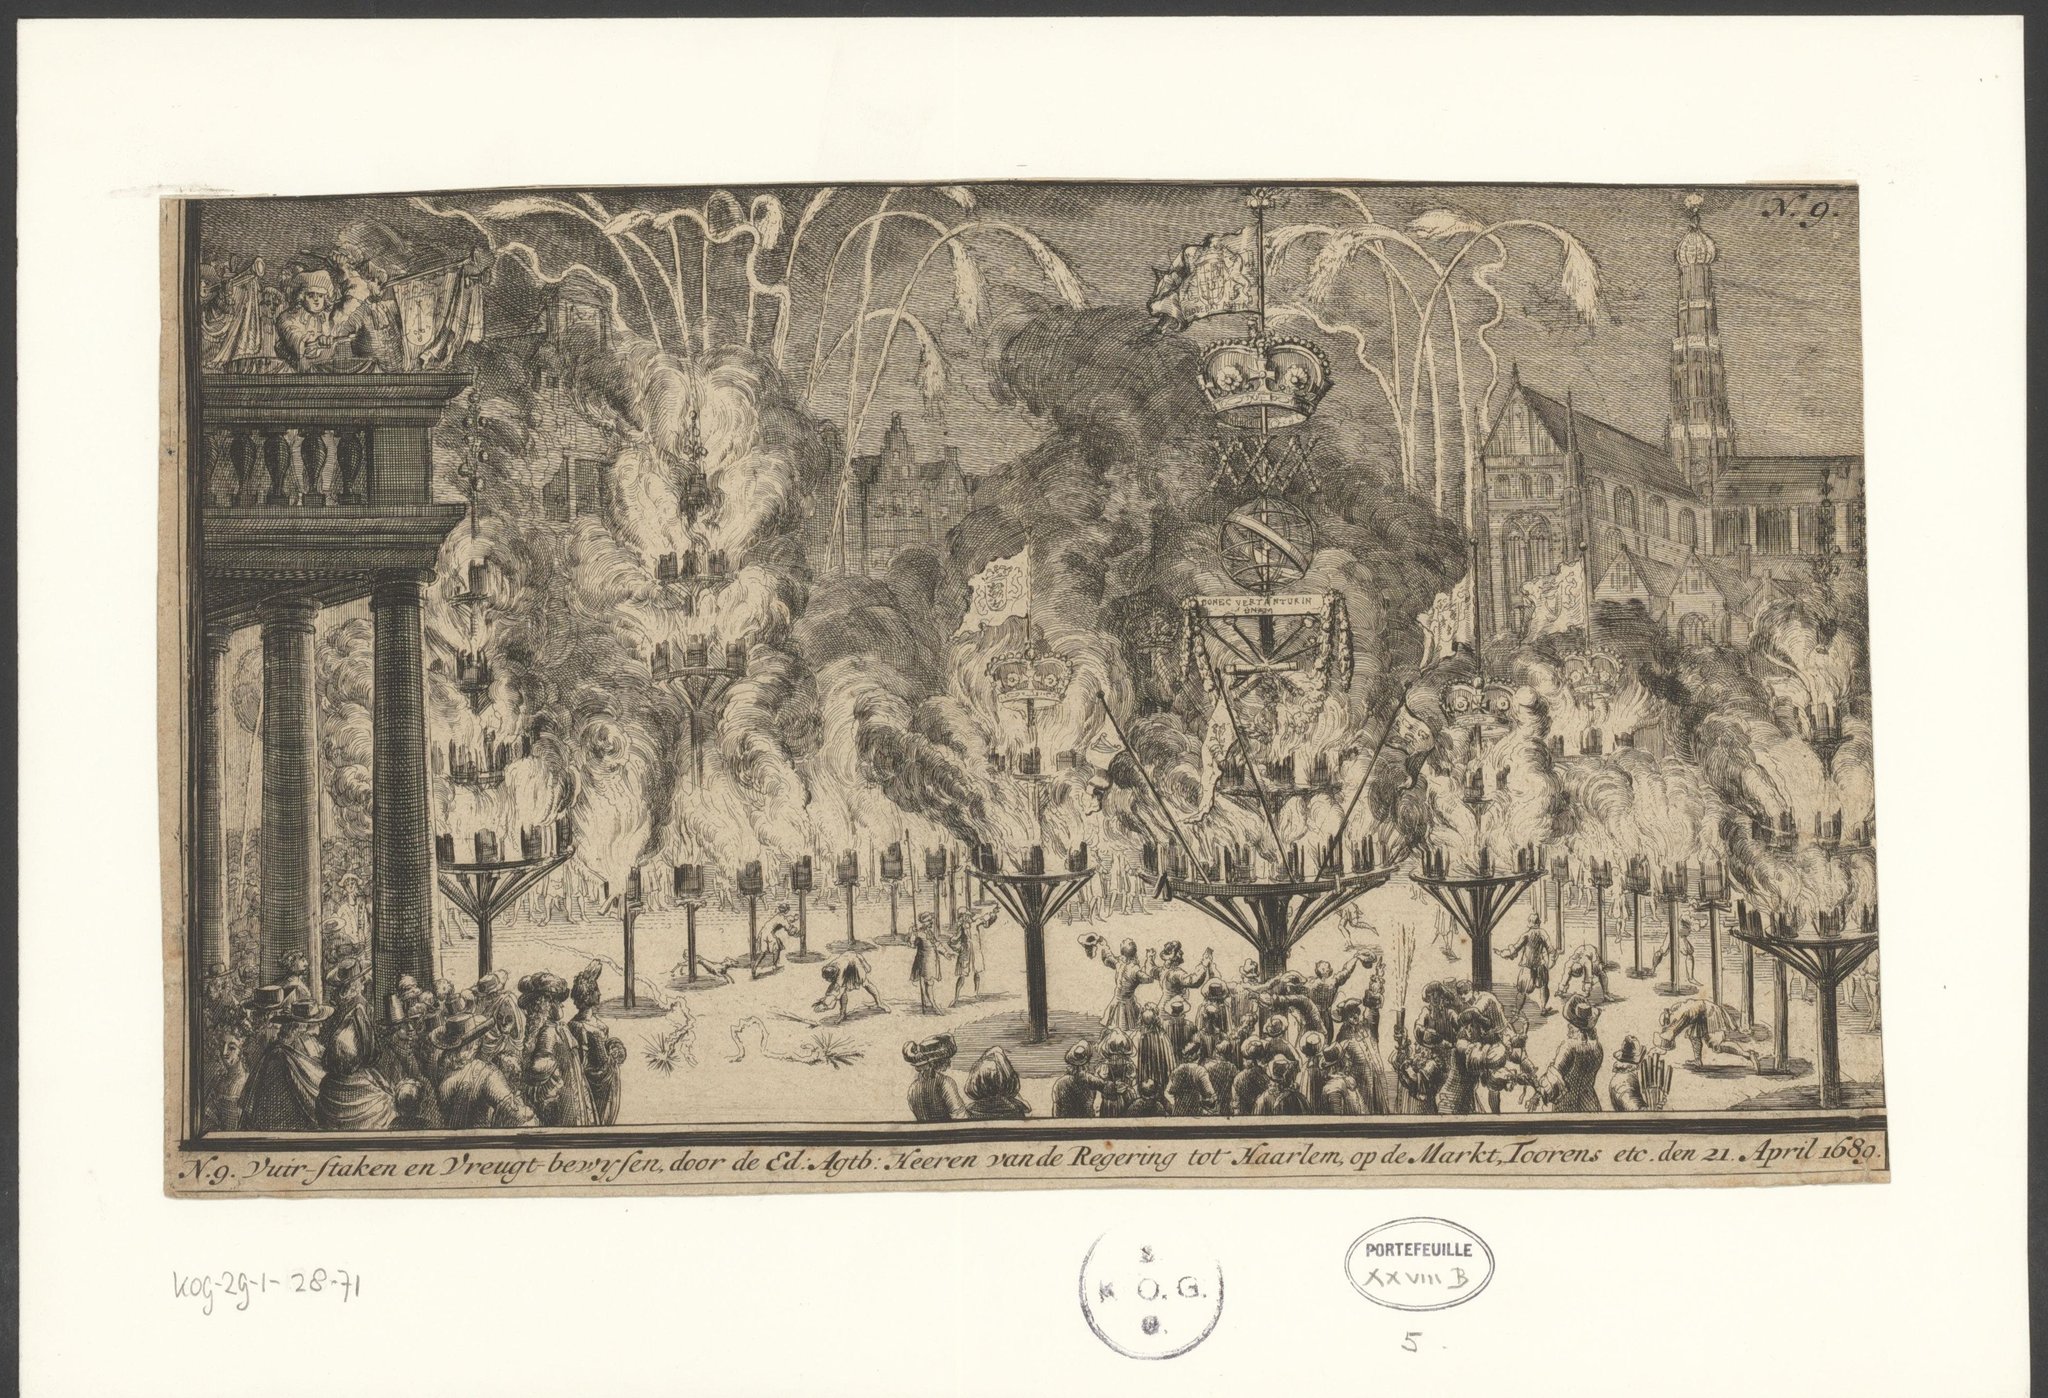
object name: print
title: Vuurwerk op de Grote Markt te Haarlem ter ere van de kroning van Willem III en Maria II Stuart, 1689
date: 1689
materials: paper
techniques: etching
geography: amsterdam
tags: william iii (prince of orange and king of england, scotland, and ireland), london, maria ii stuart (koningin van engeland, schotland en ierland), public festivities at other royal events, not meant or mentioned above (+ illumination, fire-works ~ festive activities), bonfire, fire-works, haarlem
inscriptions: collector's mark: Lugt 1641, stamp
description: Vuurwerk ter ere van de kroning van Willem III en Maria II tot koning en koningin van Groot-Brittannië, 21 april 1689. Onderwerpsrubrieken binnen de Atlas Zeden en Gewoonten: Zeden en Gewoonten in Engeren Zin. Volksleven. Openbare feesten. Vorstelijke intochten, (Illuminaties, vuurwerken en dergelijke, openbare feesten).